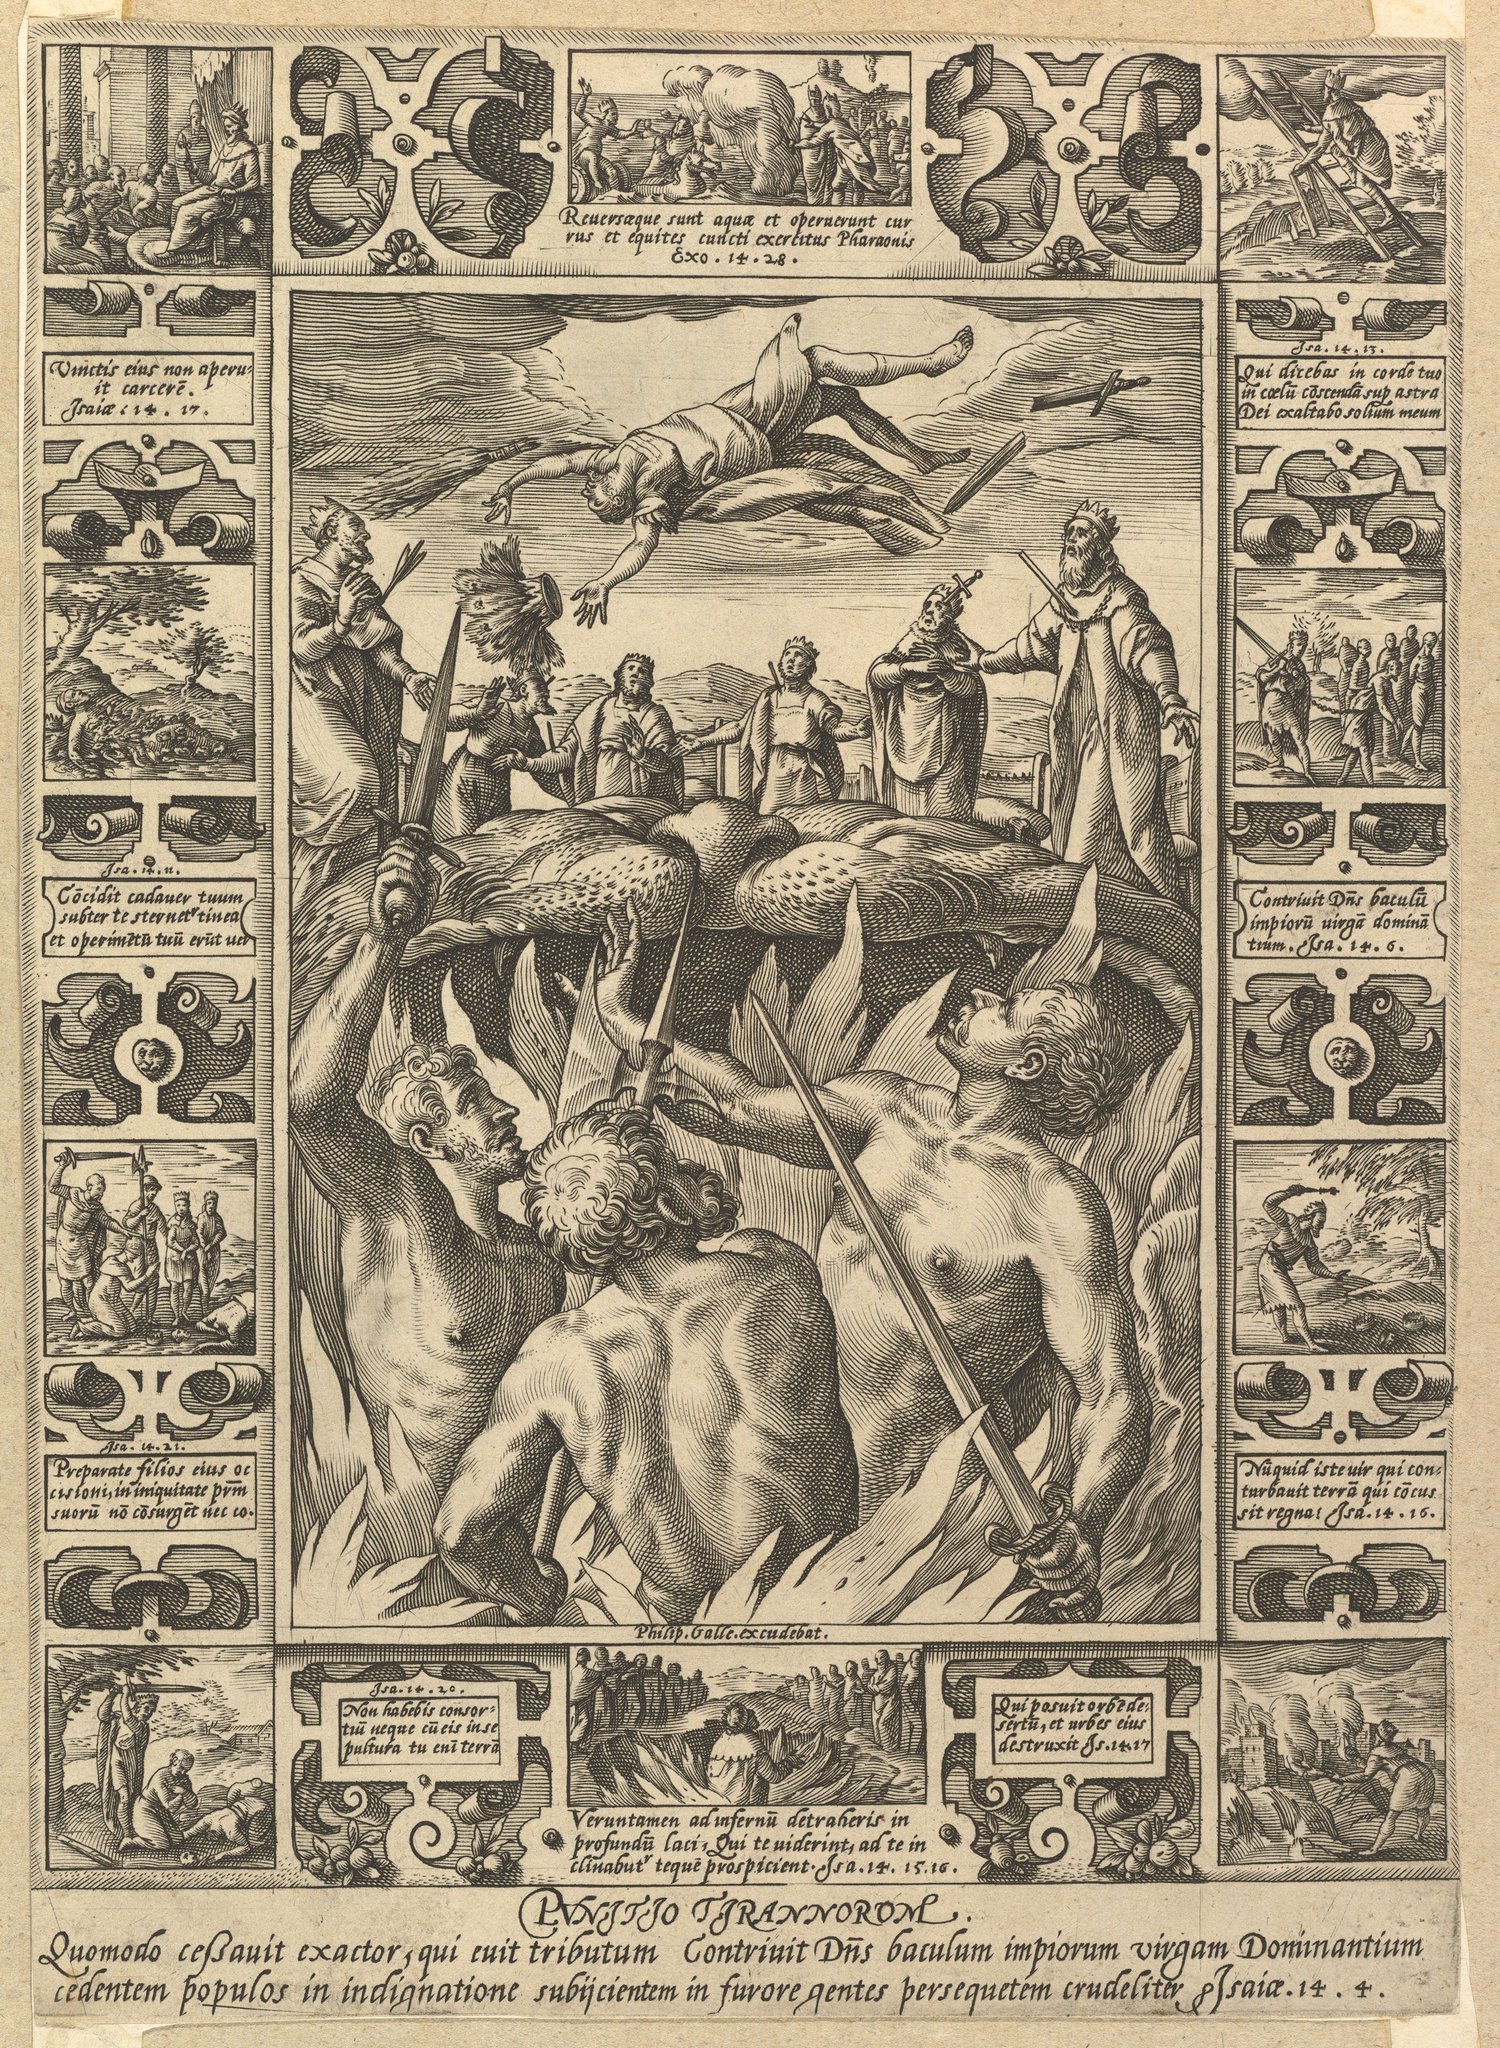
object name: print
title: Punitio Tirannorum, from "Allegories of the Christian Faith, from Christian and Profane Allegories"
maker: hendrick goltzius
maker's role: artist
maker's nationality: netherlandish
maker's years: 1558-1617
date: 1560-1617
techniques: engraving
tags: swords,men,fire,saints,punishment